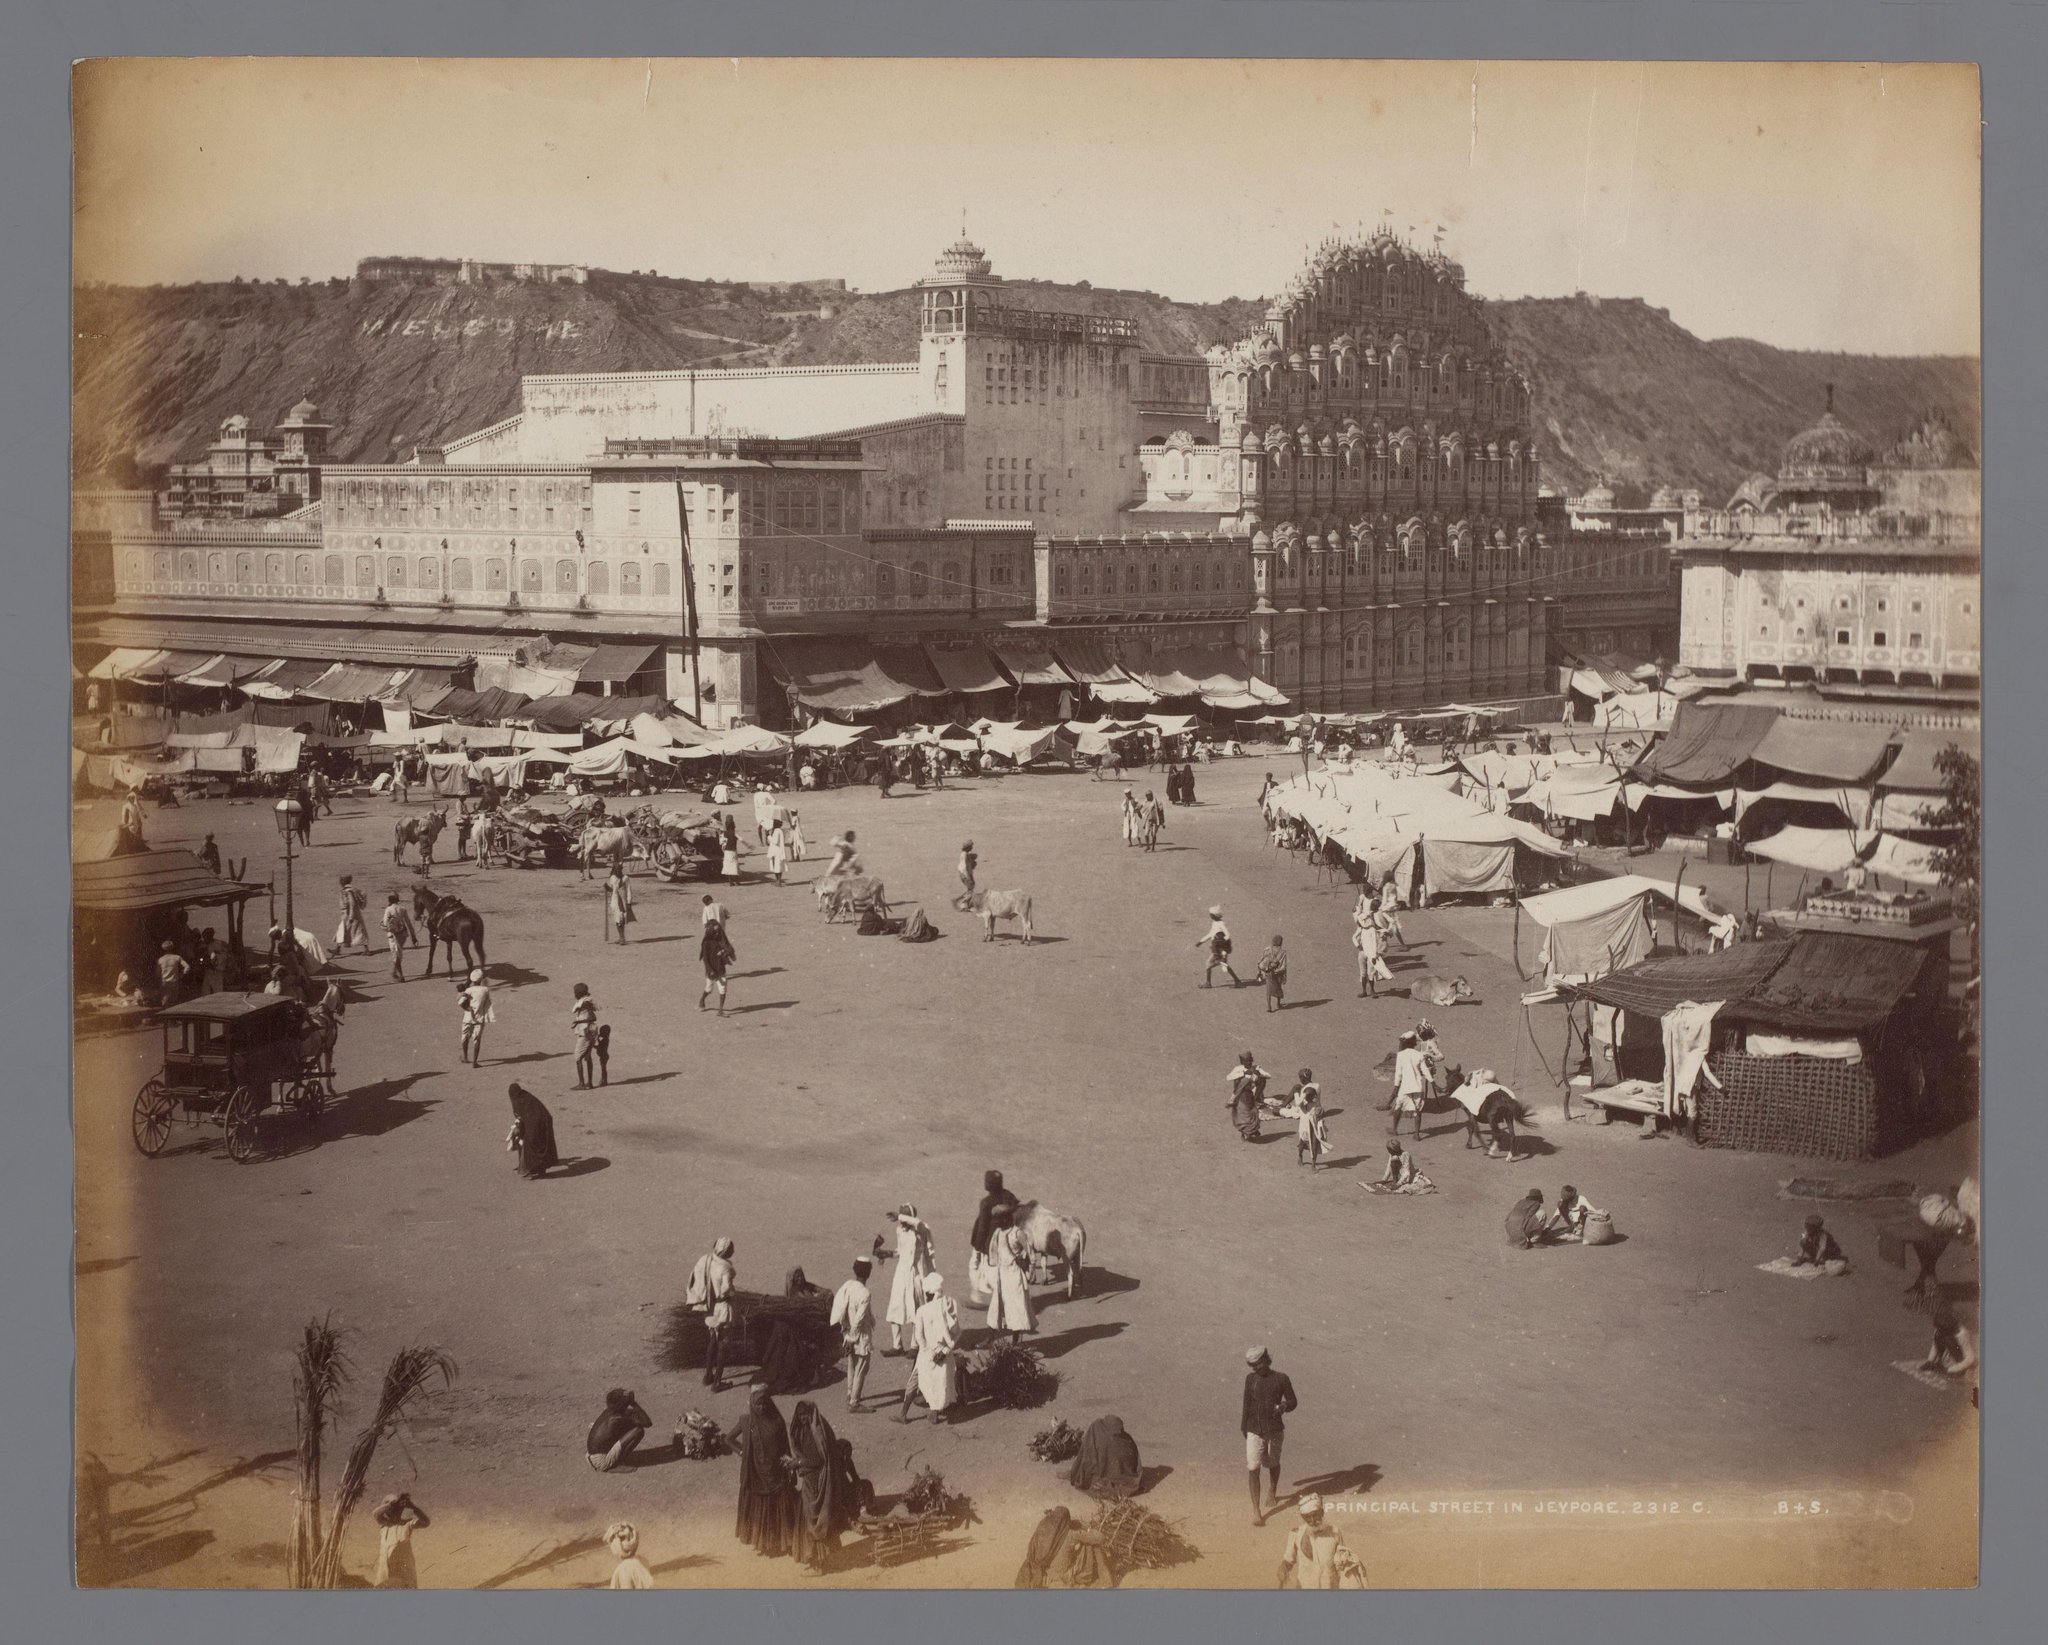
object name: photograph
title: View of the Hawa Mahal, Jaipur, Rajasthan, India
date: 1863-1900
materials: paper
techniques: albumen print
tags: hawa mahal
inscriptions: inscription: ‘The Howa Mahal/ Palace of the Winds.’, number: ‘2312. c.’, title: ‘PRINCIPAL STREET IN JEYPORE. 2312 C. B+S.’, number: ‘44’, number: ‘4/43’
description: Het Hawa Mahal paleis in Jaipur is een voorbeeld van de post-mogol bouwkunst en niet zozeer een echt paleis maar eerder een gevel met daarin 953 ramen, balkons en nissen verspreid over vijf verdiepingen. Het gebouw werd in 1799 in opdracht van de toenmalige Maharaja Sawai Pratap Singh gebouwd. Het gebouw had het doel om de haremvrouwen van de Maharadja van Rajasthan de mogelijkheid te bieden om de jaarlijkse parade te kunnen zien, zonder dat zij zelf vanaf de straat gezien konden worden. Doordat de wind door het gebouw blaast wordt het ’’Hawa Mahal’’ (Windpaleis) genoemd.